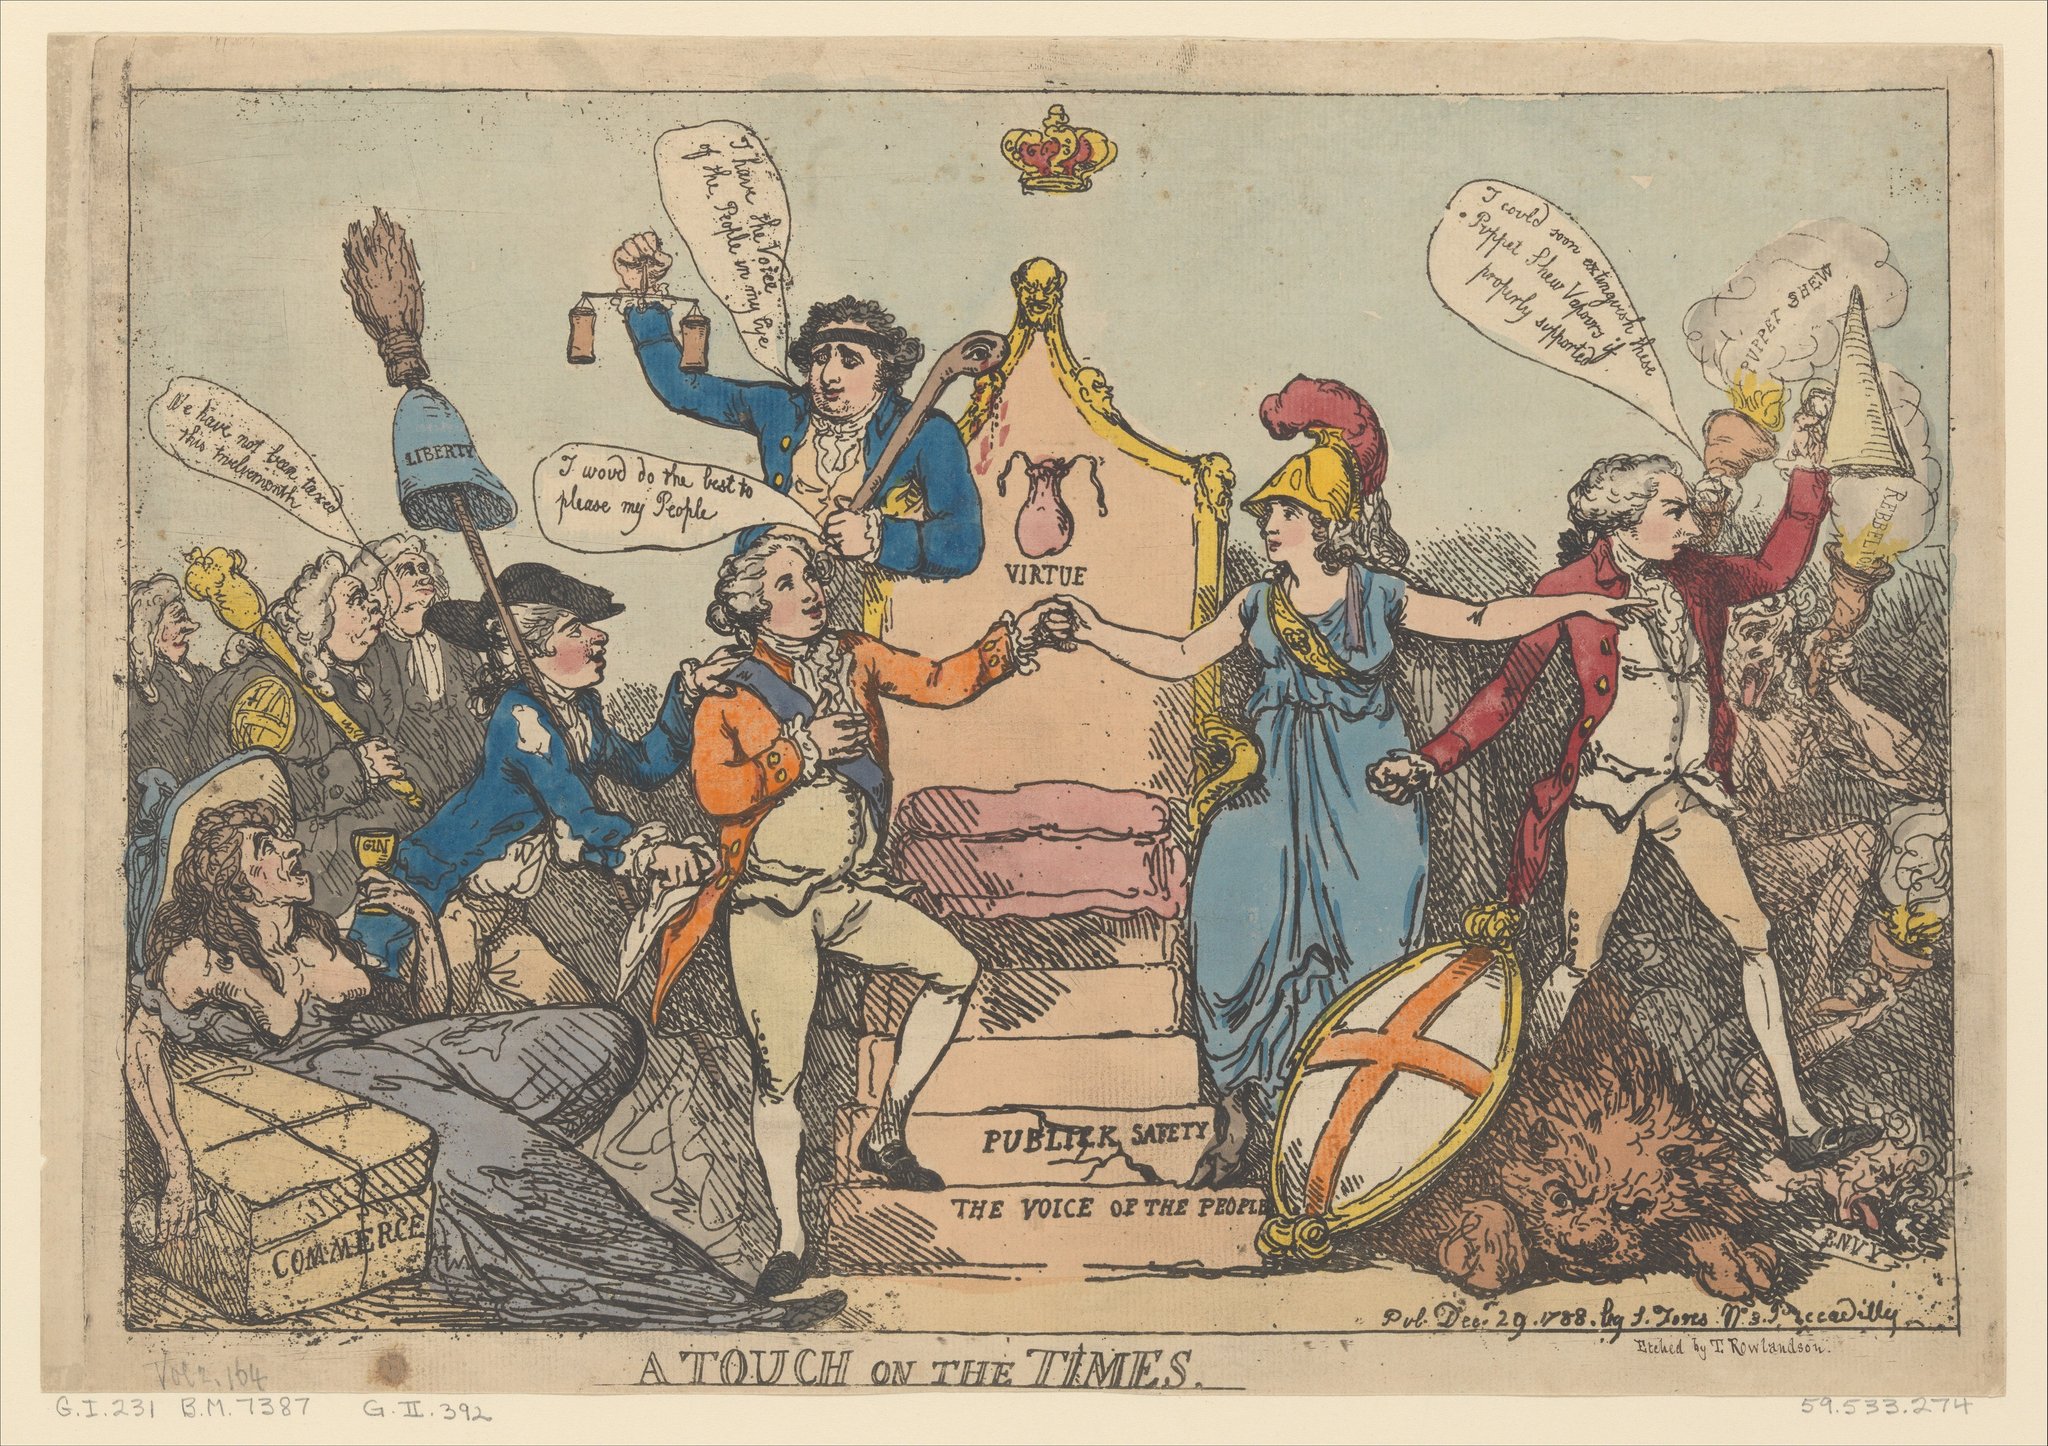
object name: print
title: A Touch on the Times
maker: thomas rowlandson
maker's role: artist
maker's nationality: british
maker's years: 1757-1827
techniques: etching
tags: satire,men,women,politics